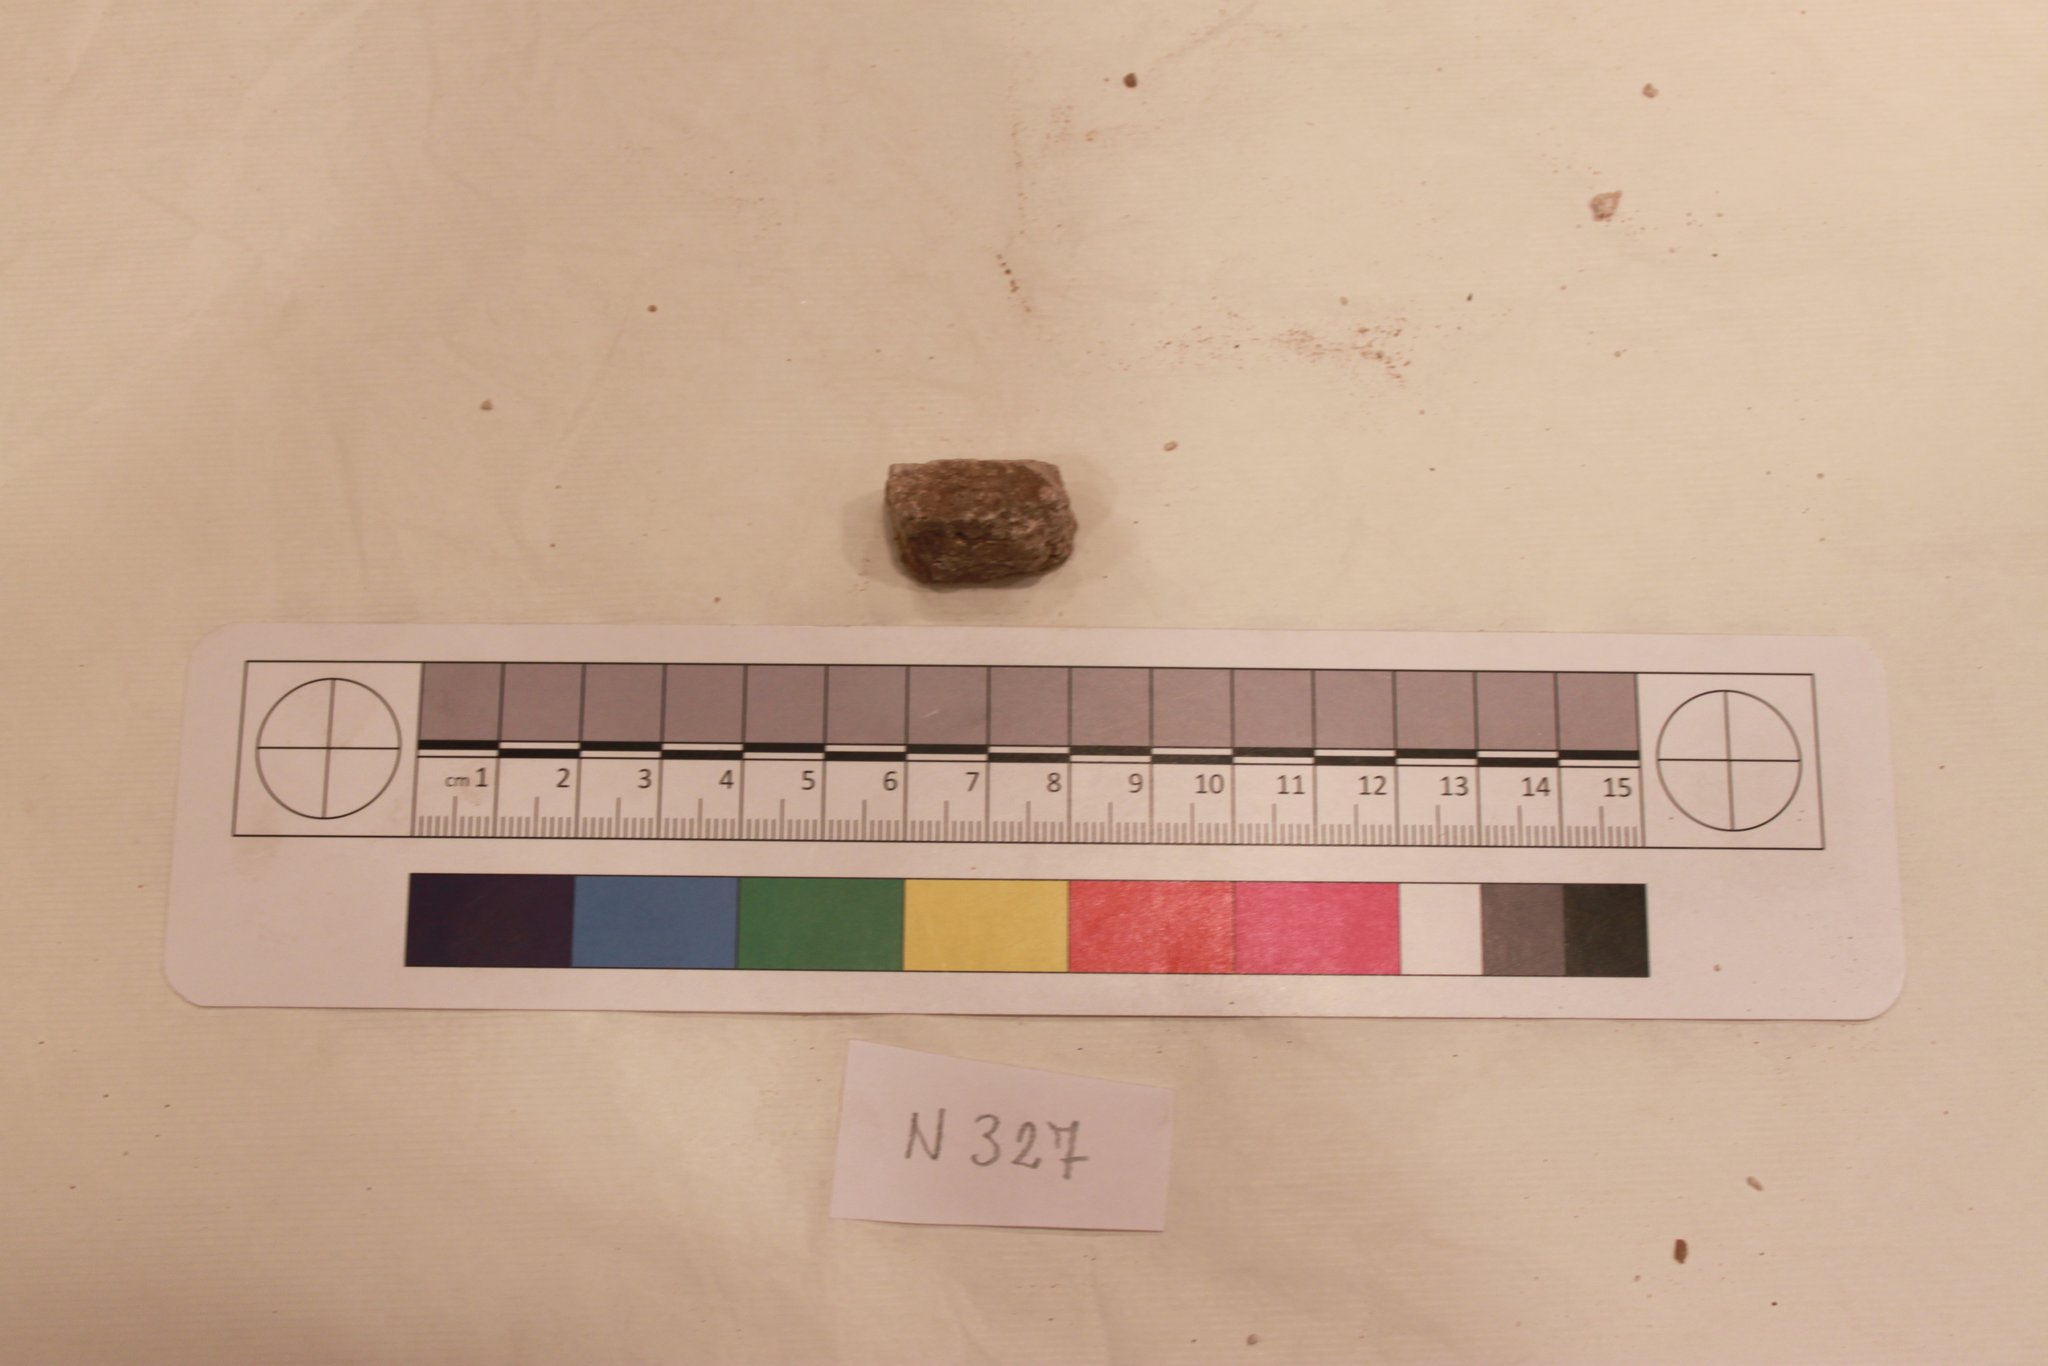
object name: fragment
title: Stucco Fragment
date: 701-1200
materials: plaster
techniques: carving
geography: iran